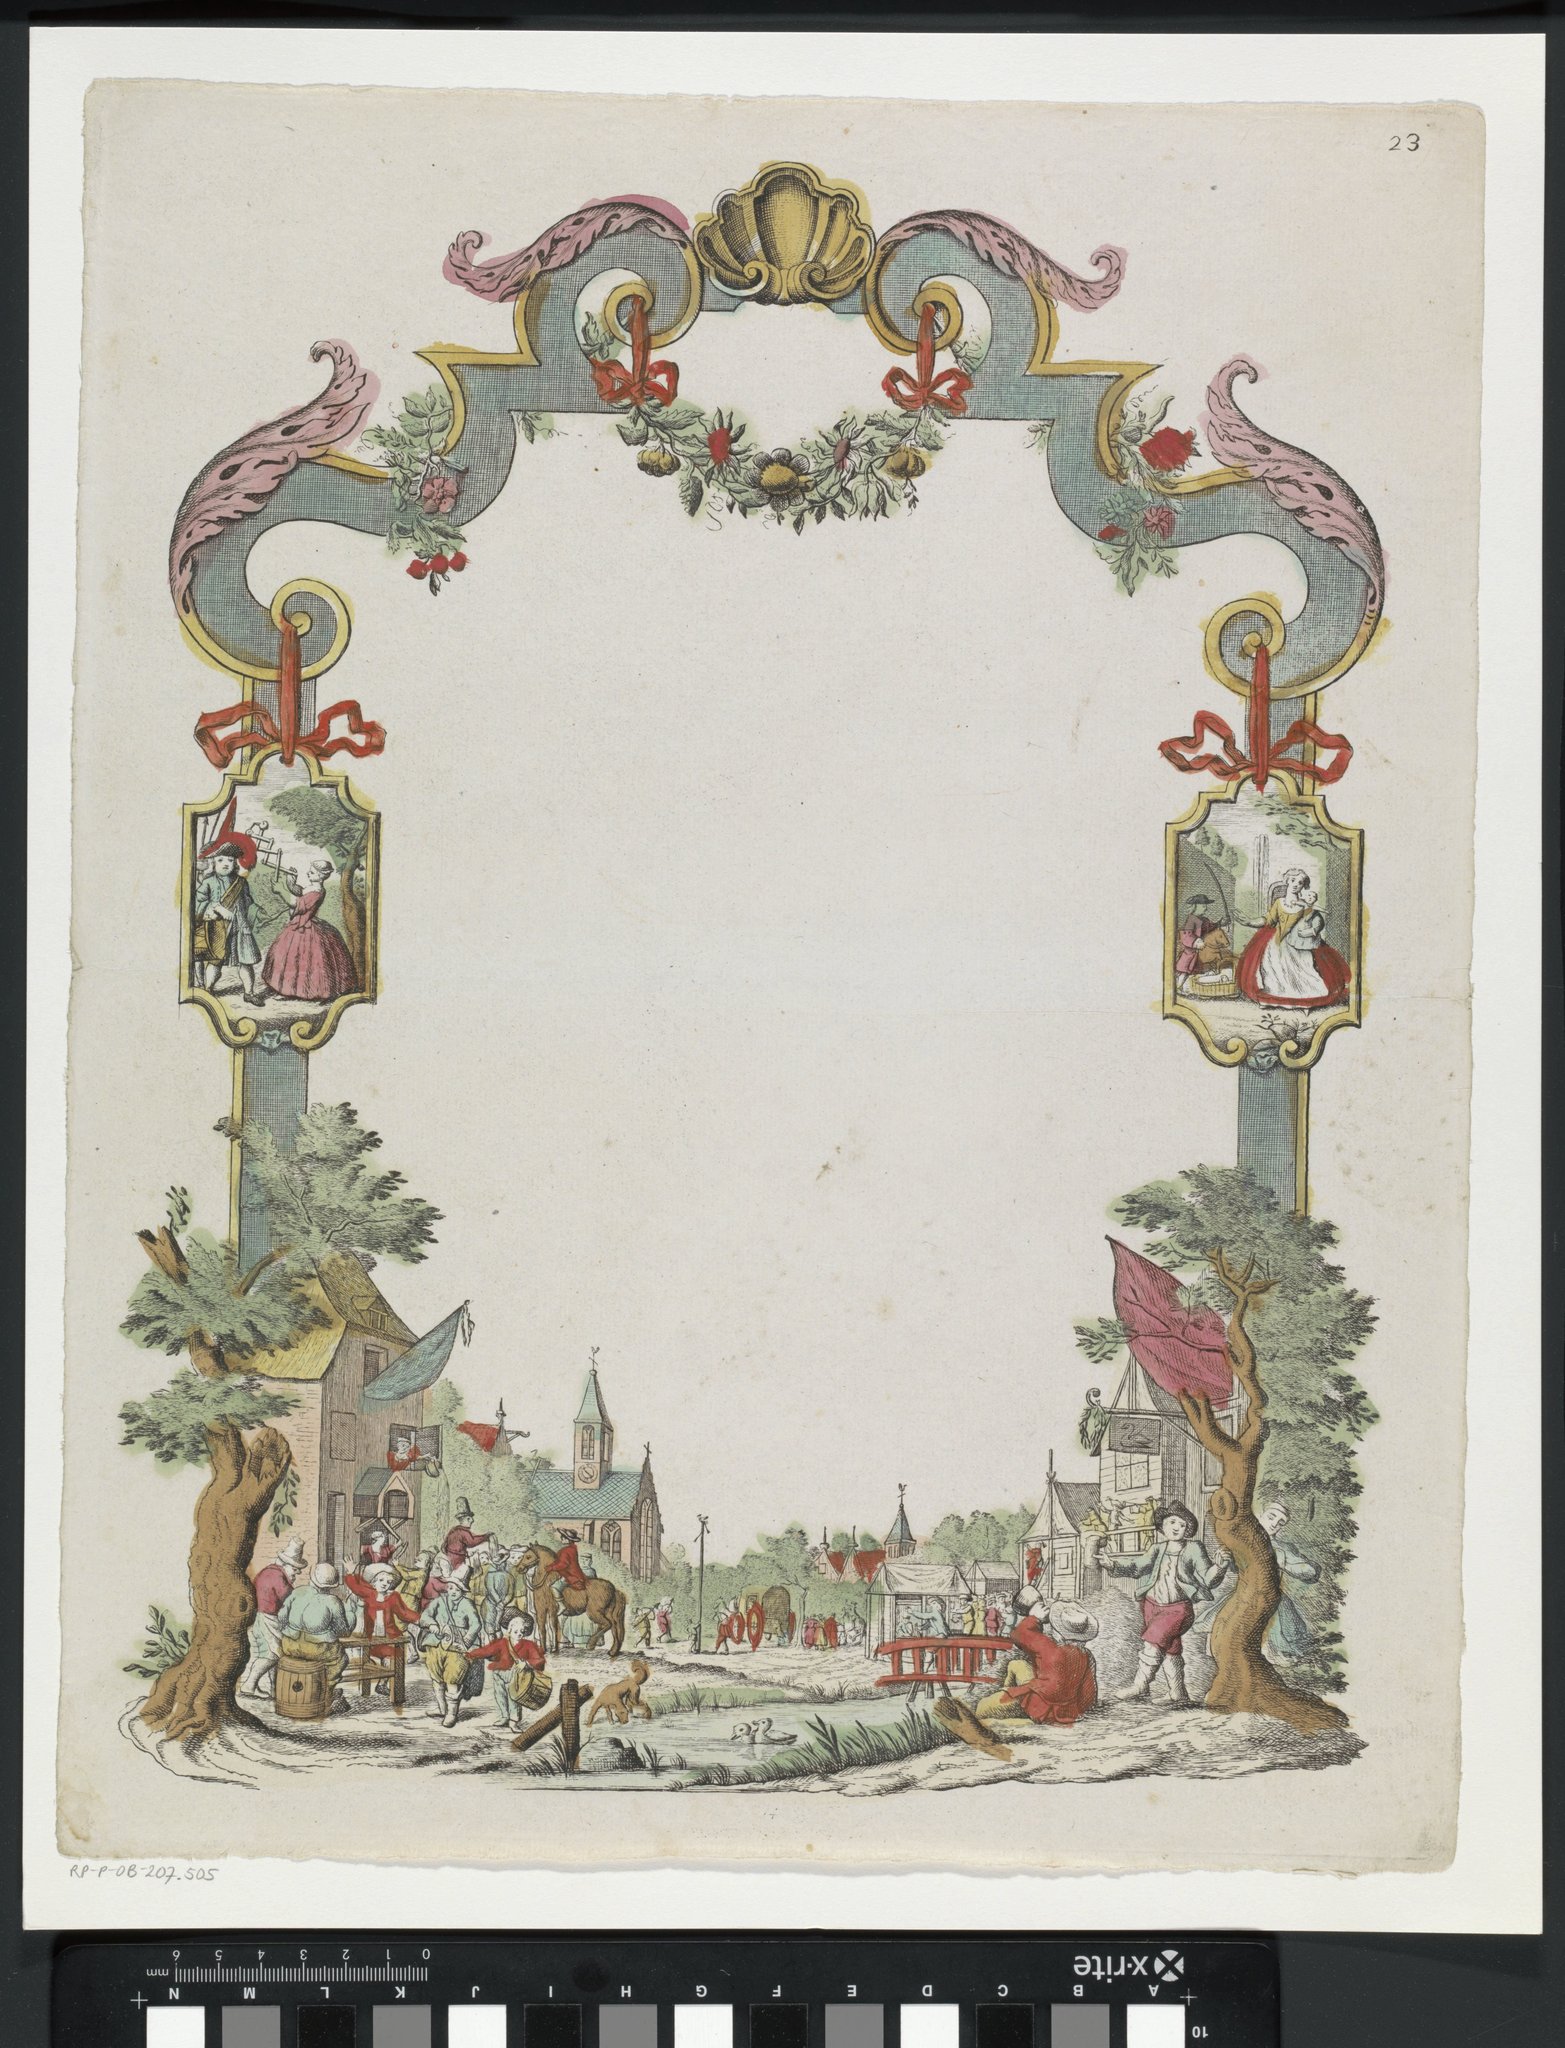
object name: wensbrief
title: Wensbrief met herbergscène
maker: Anonymous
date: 1700-1899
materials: paper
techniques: colour, etching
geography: amsterdam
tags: farmers, drinking, hotel, hostelry, inn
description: Wensbrief met onbeschreven cartouche binnen een decoratief kader met drinkende boeren voor een herberg. Genummerd rechtsboven: 23.